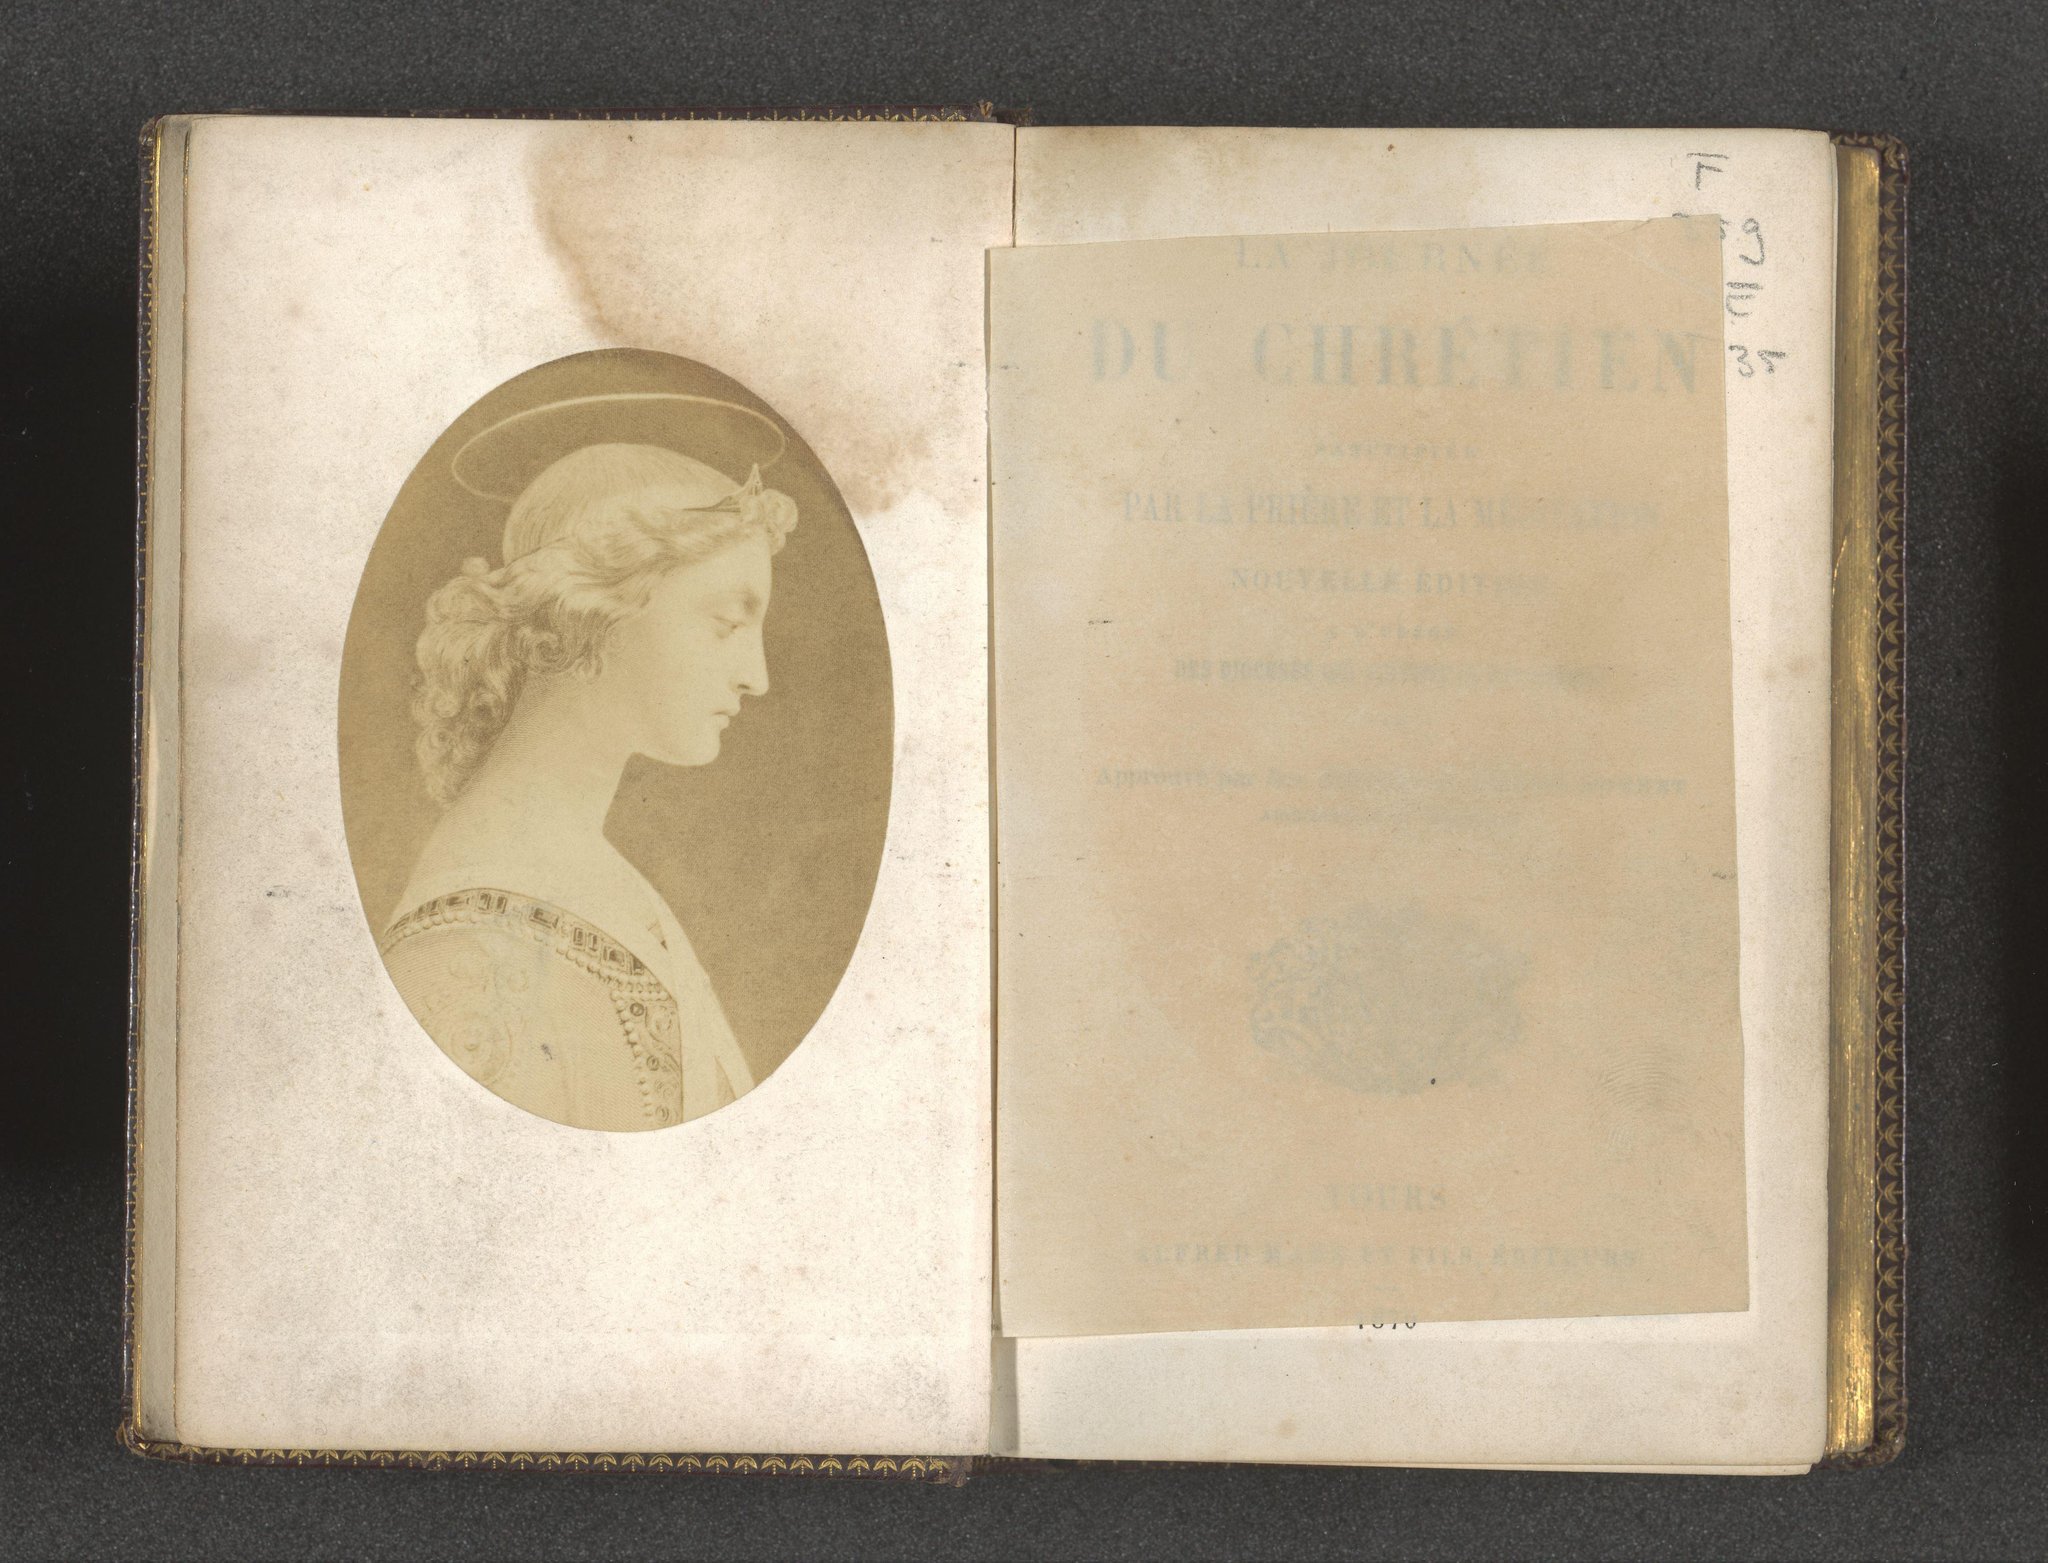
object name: page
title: Fotoreproductie van vermoedelijk een schilderij of prent van een onbekend Bijbels figuur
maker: Anonymous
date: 1865-1870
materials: photographic support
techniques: albumen print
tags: saints